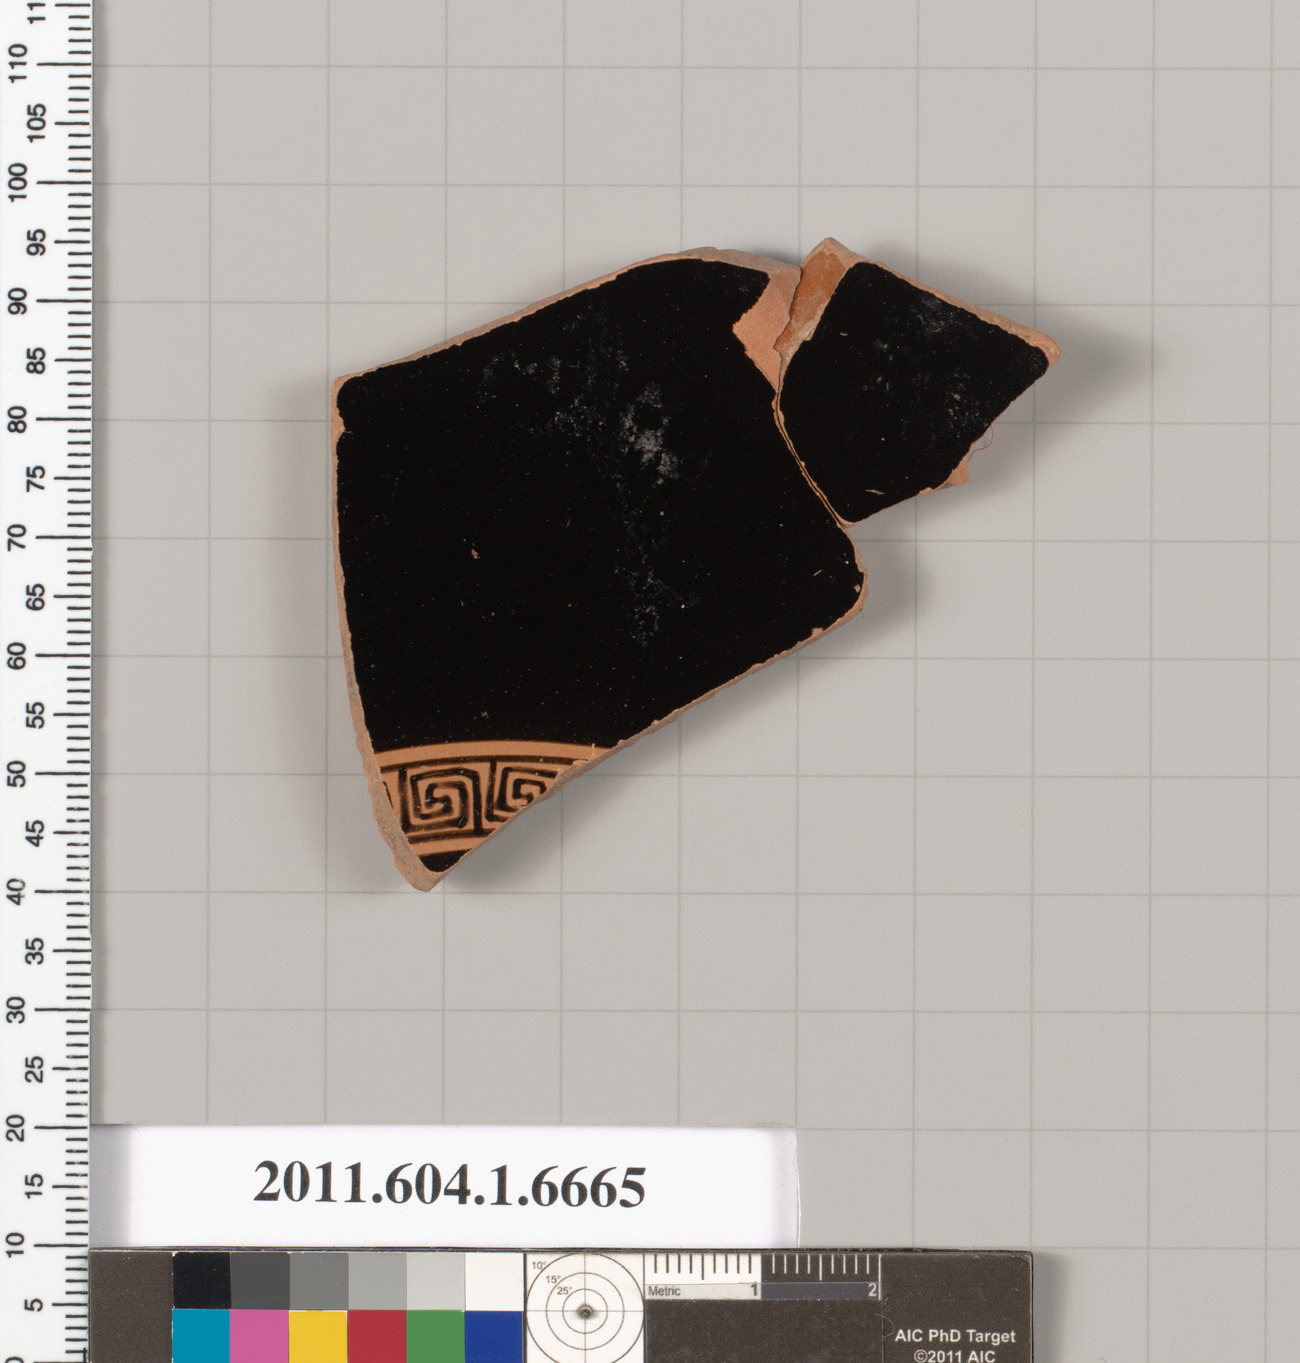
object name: kylix fragment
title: Terracotta fragment of a kylix (drinking cup)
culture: greek, attic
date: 490-470 BCE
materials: terracotta